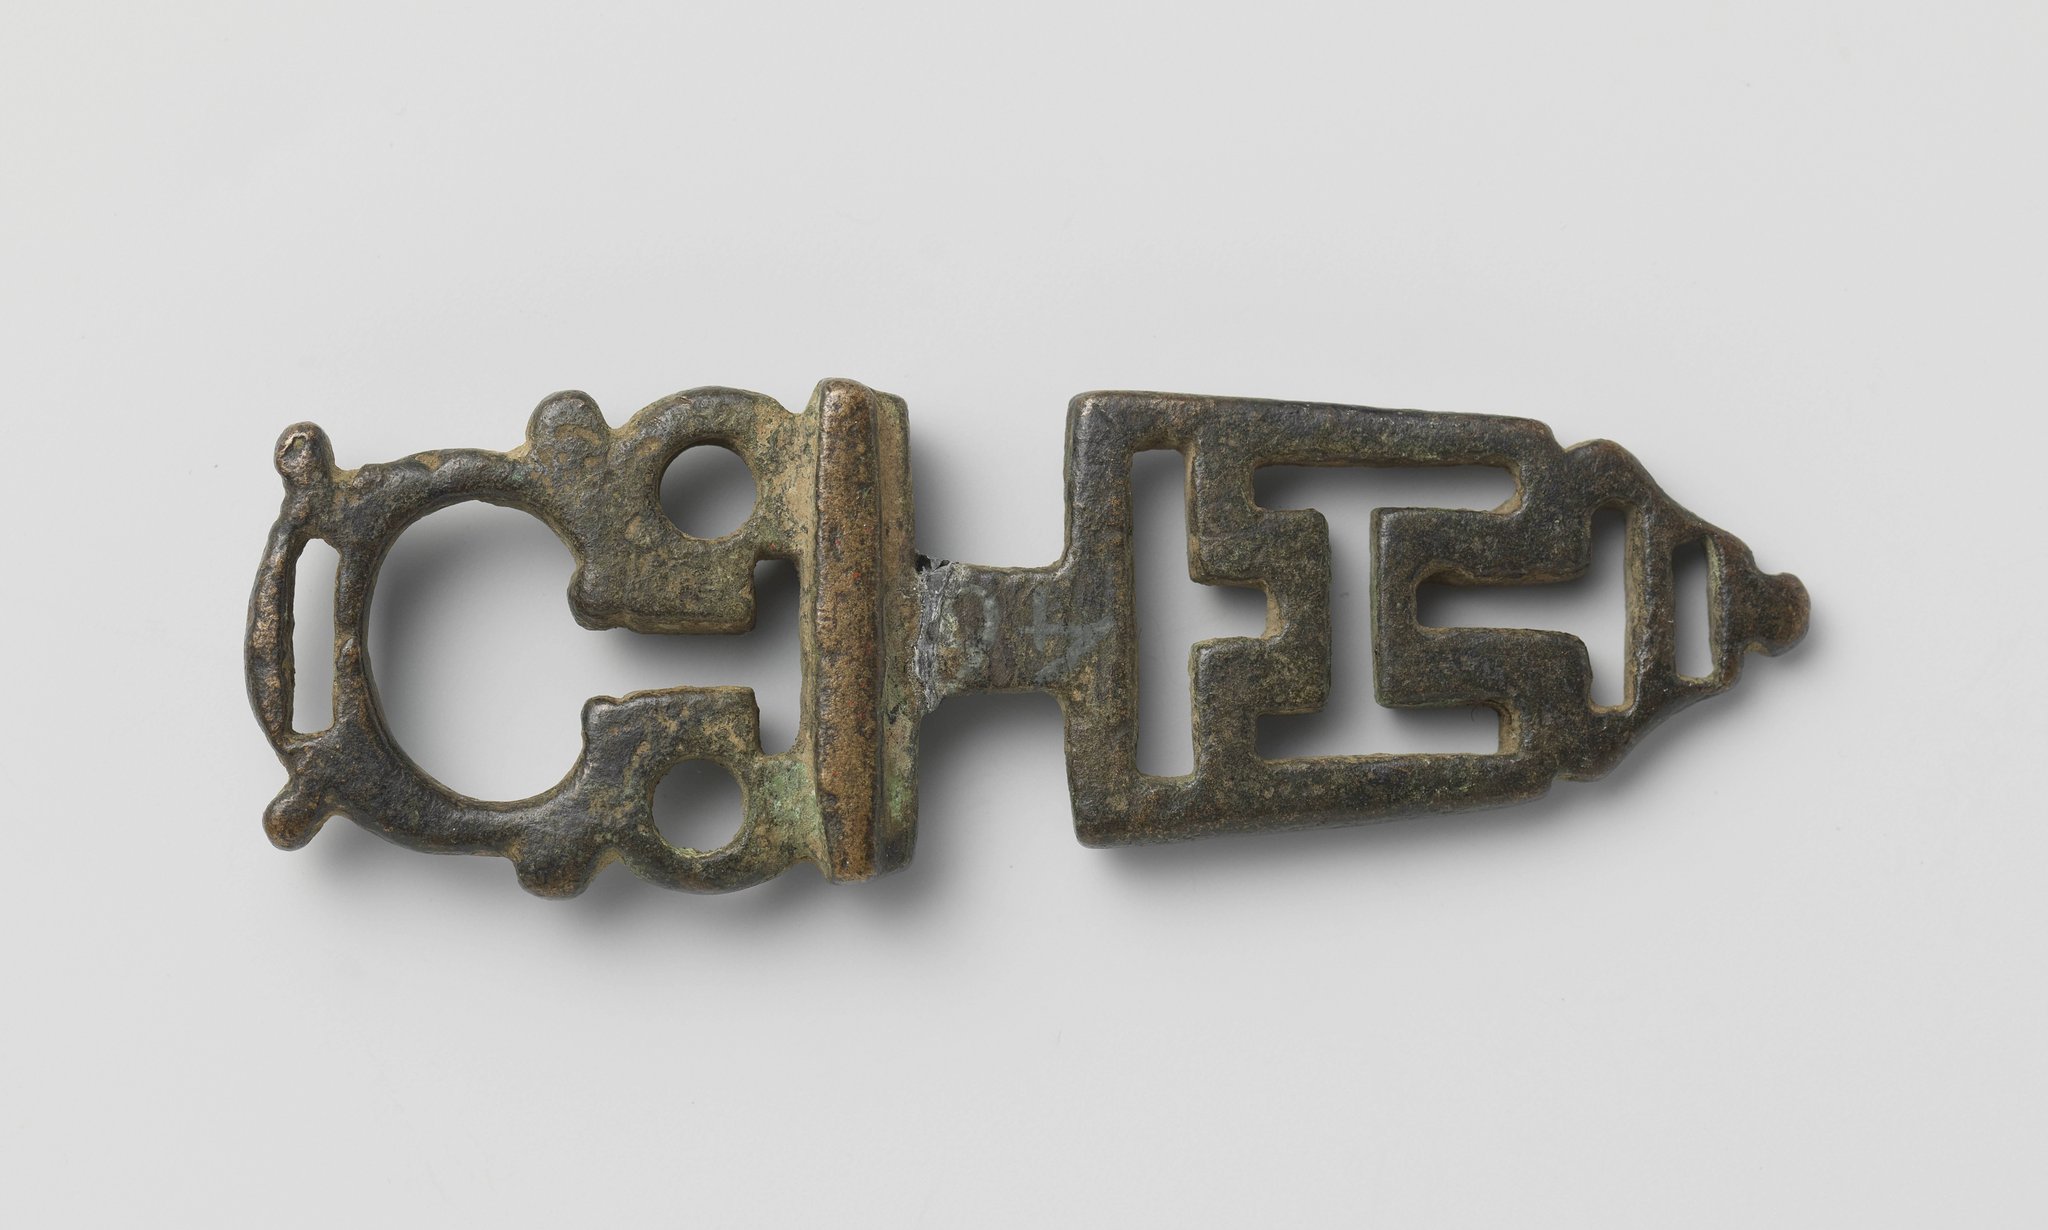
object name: schuifsleutel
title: Key latch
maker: Anonymous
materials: bronze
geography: rome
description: Schuifsleutel met greep bestaande uit een beugel waaronder weer twee oogjes geplaatst zijn die op de zware sleutelborst rusten. Baard aan het einde puntig toelopend.